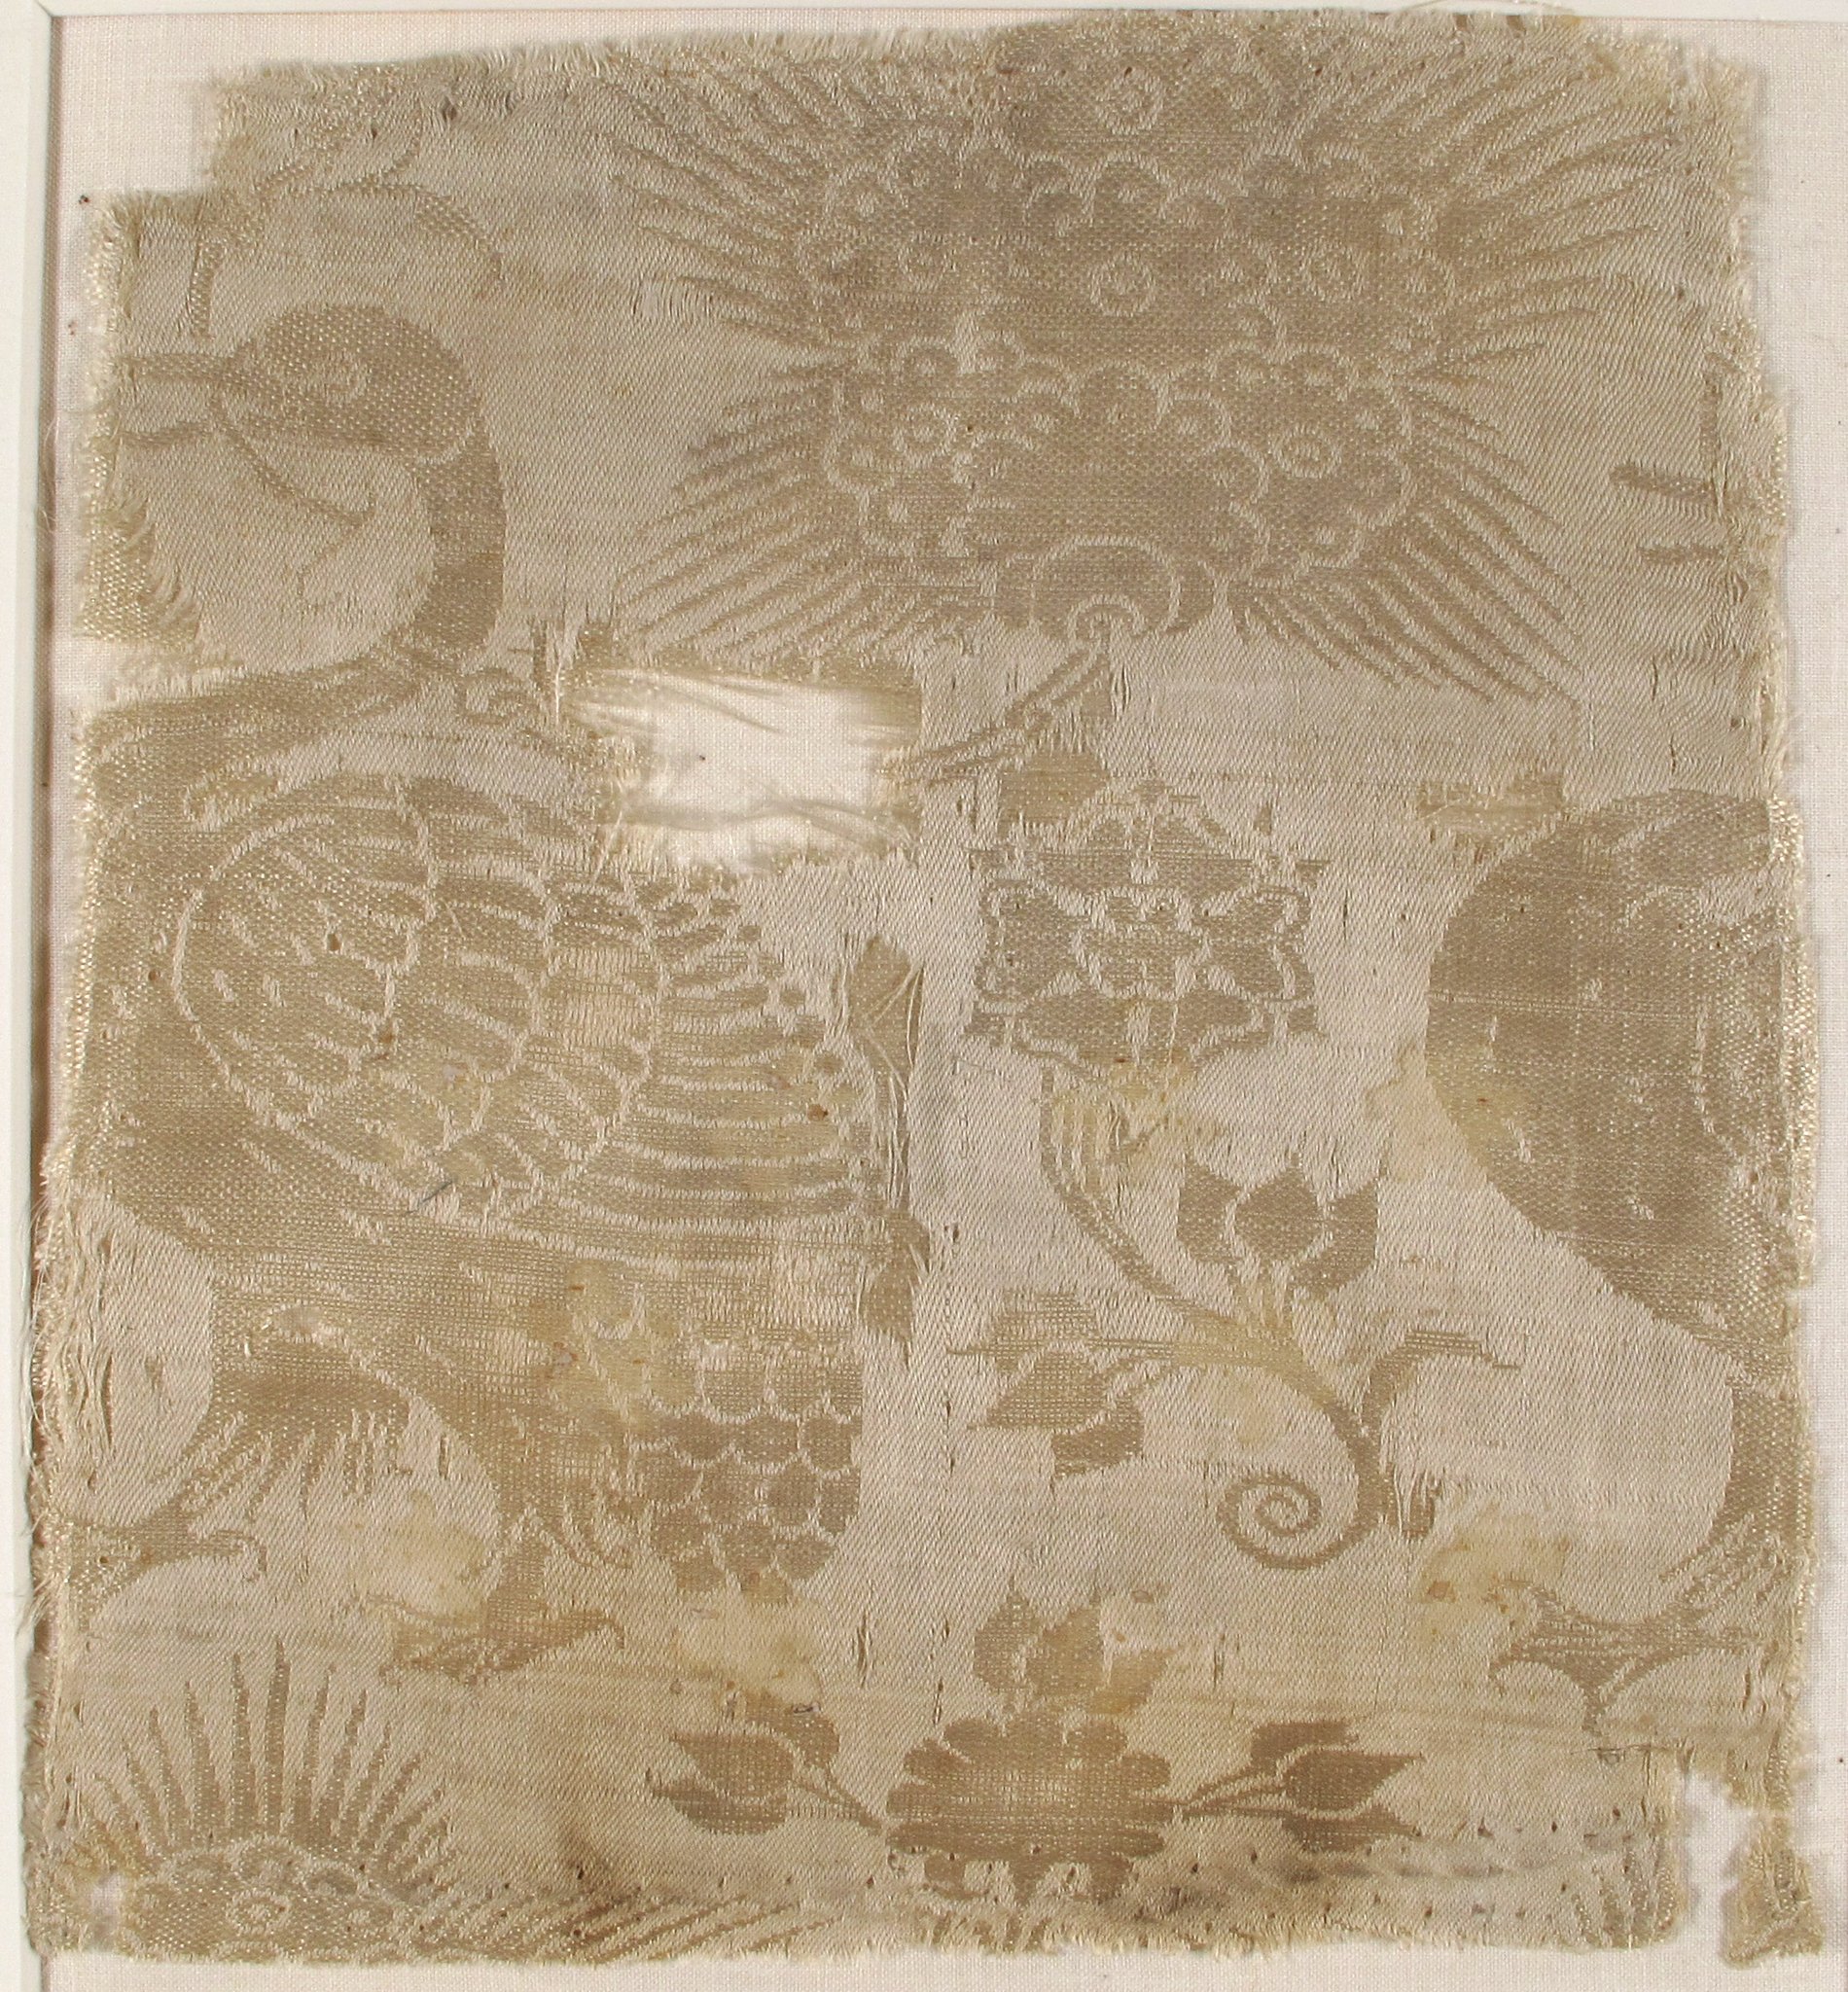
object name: damask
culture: italian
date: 1301-1400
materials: silk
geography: italy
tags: birds,flowers